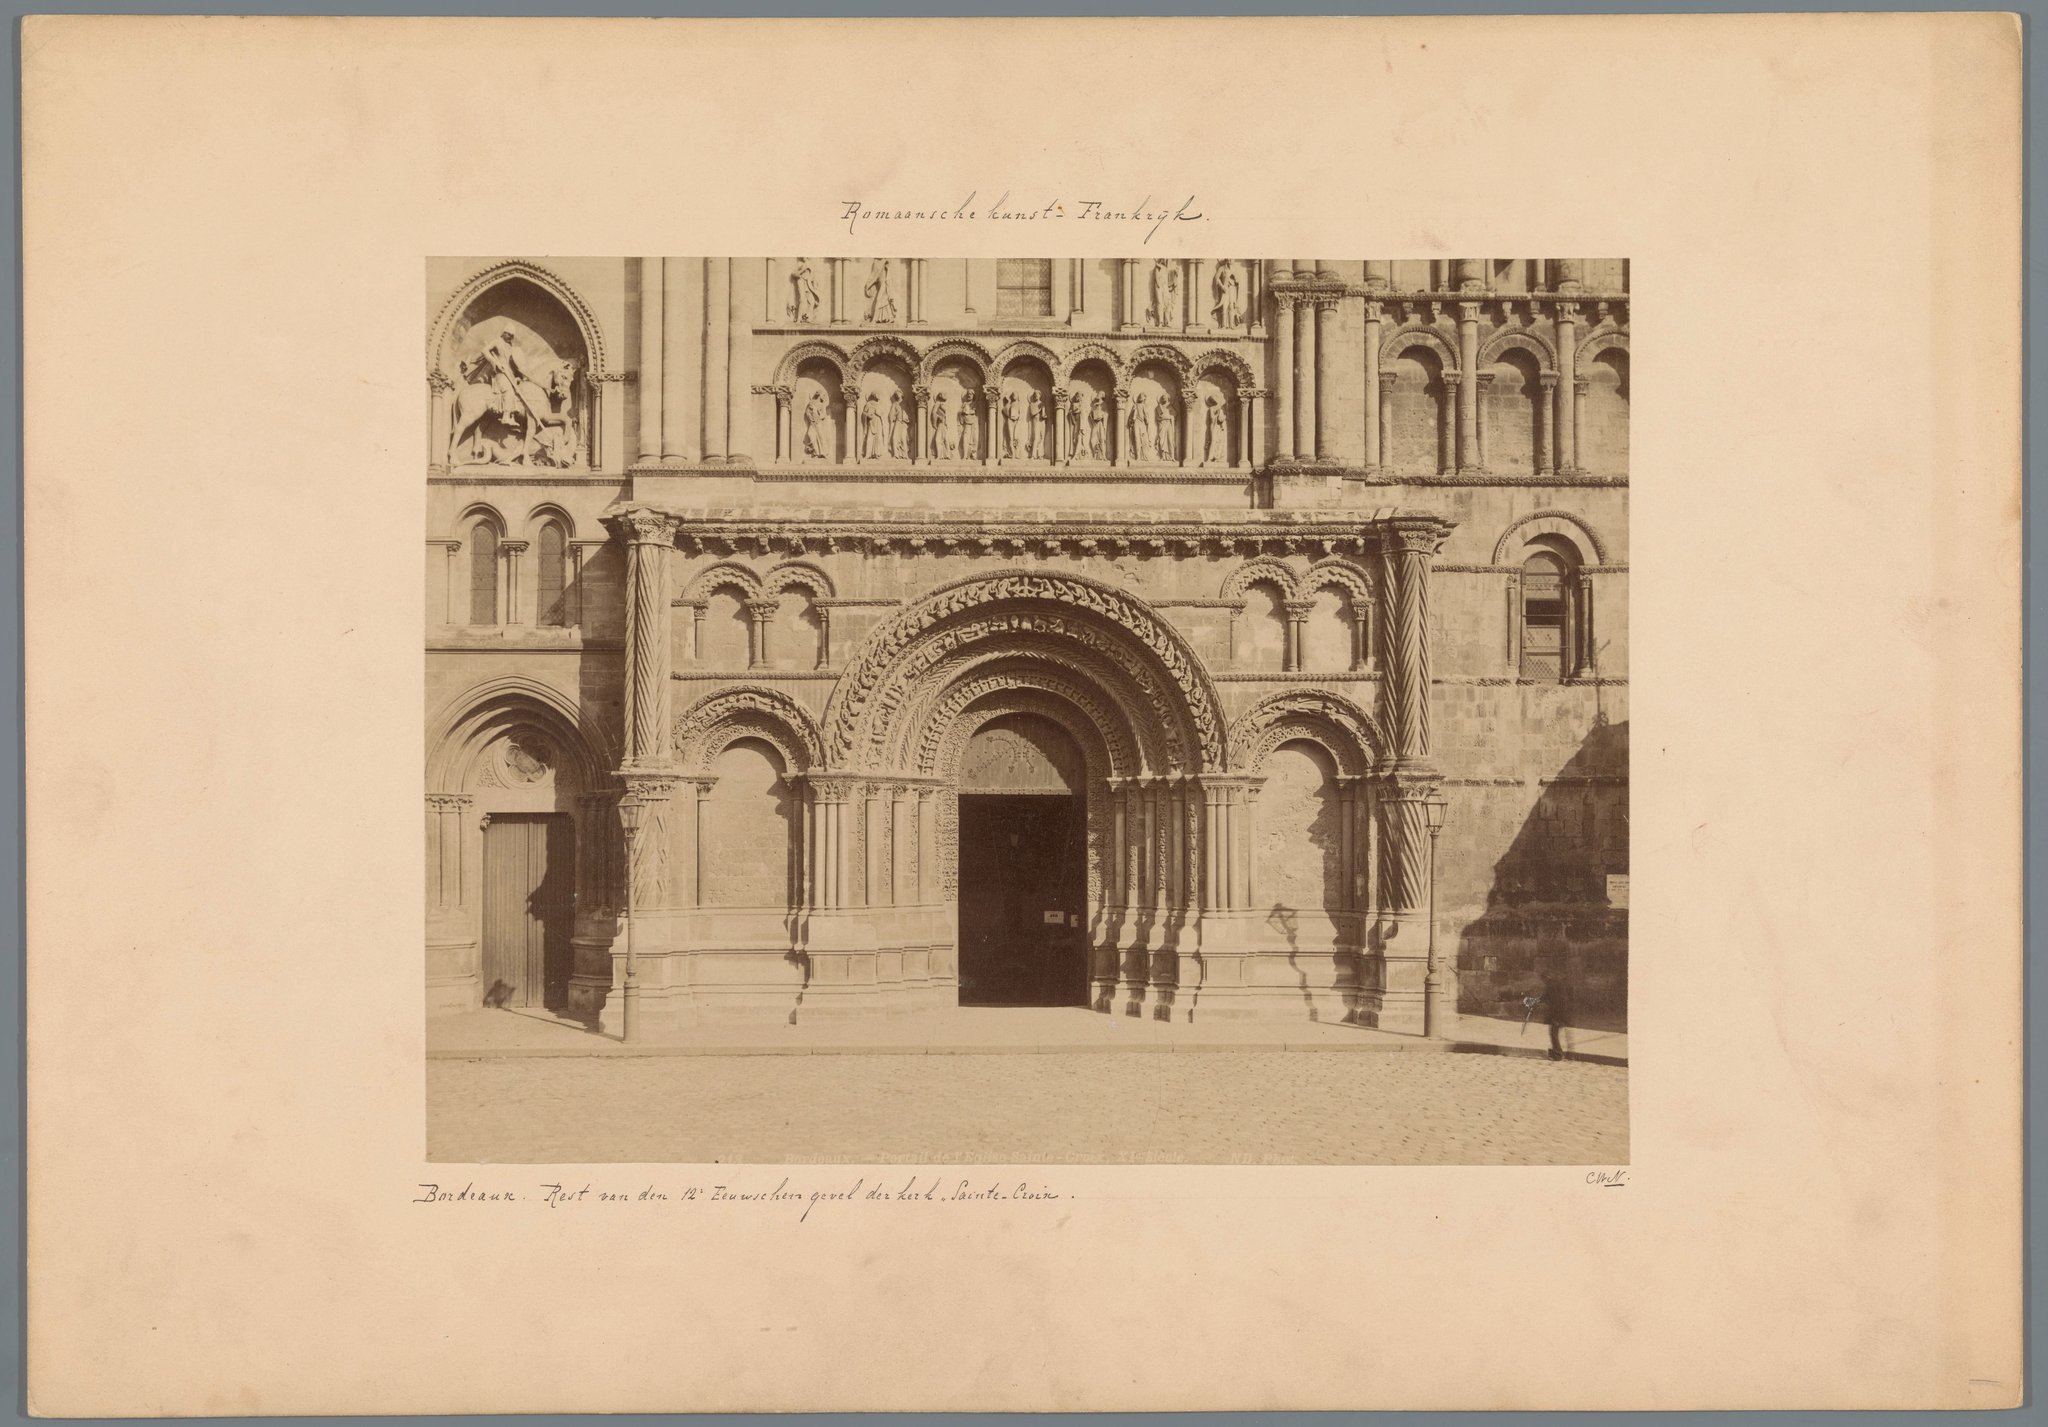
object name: photograph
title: Bordeaux. - Portail de l'Eglise Sainte-Croix, XIe Siècle.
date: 1875-1900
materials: cardboard, photographic support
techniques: albumen print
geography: bordeaux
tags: parts of church exterior and annexes: portal, church (exterior), gate, entrance, façade (of house or building)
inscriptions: collector's mark: ‘KUNSTNIJVERHEIDSCHOOL QUELLINUS AMSTERDAM FRANS HALSSTRAAT 14.’, number: ‘213’, collector's mark: ‘INSTITUUT VOOR KUNST- NIJVERHEIDSONDERWIJS GABRIËL METSUSTRAAT No. 16. AMSTERDAM’, inscription: ‘CWN.’, inscription: ‘Romaansche kunst - Frankrijk. Bordeaux. Rest van den 12e Eeuwschen gevel der kerk ,,Sainte-Croix .’